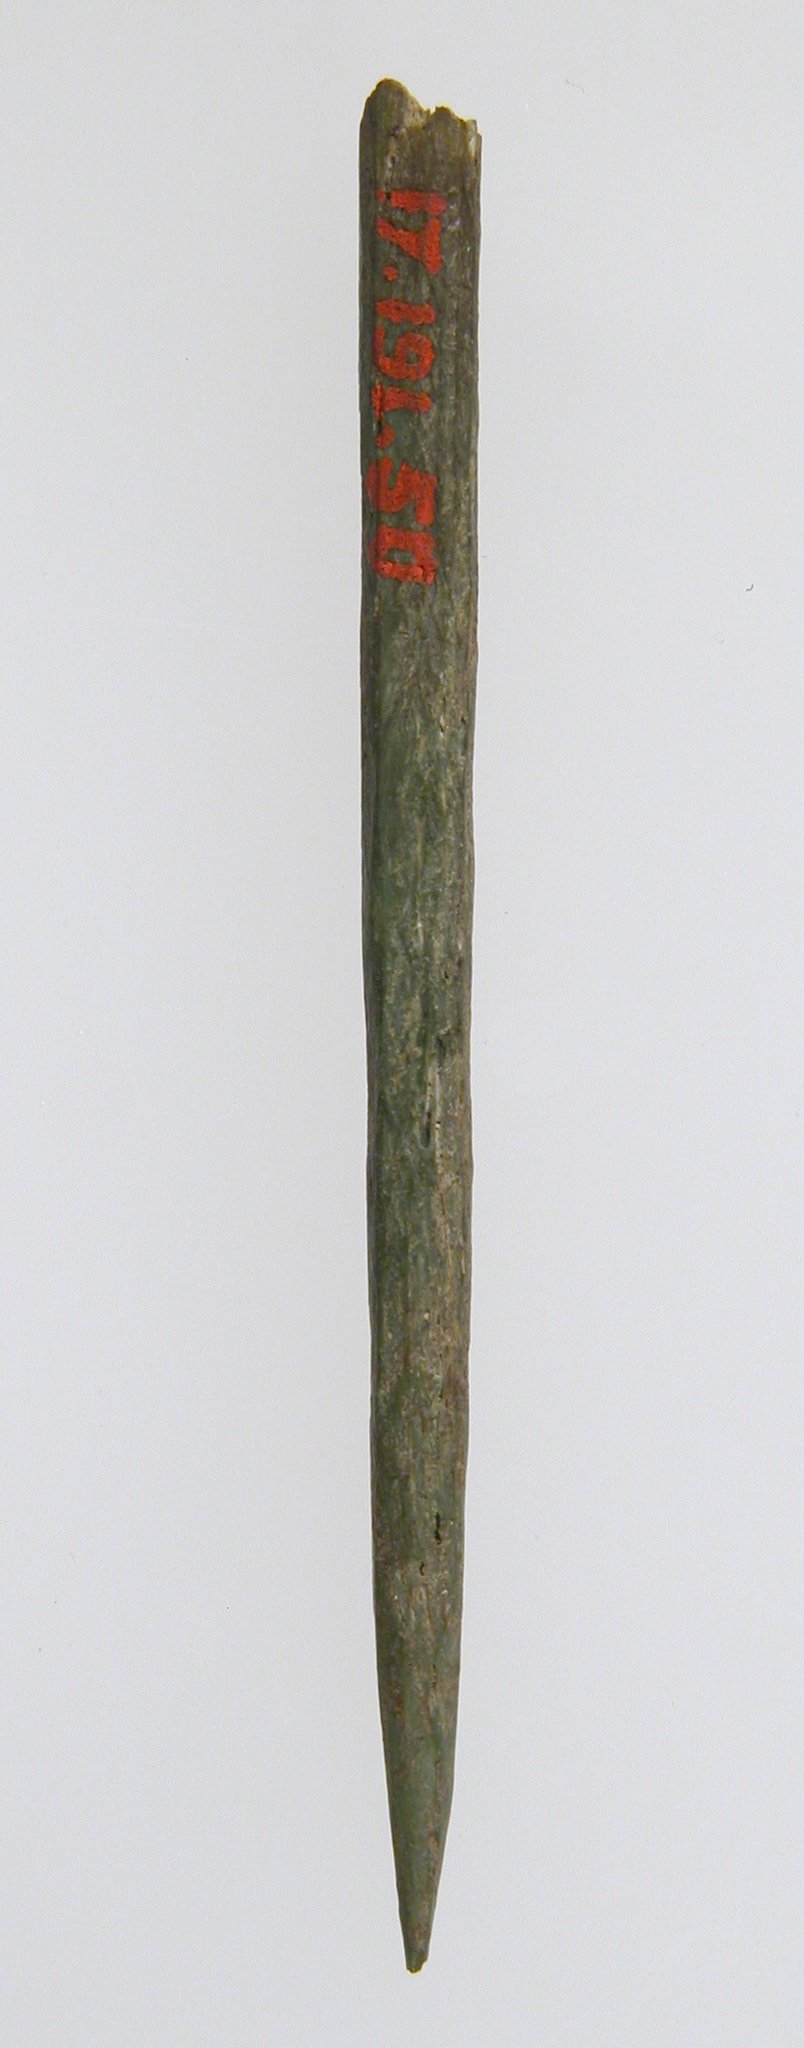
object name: hairpin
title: Hairpin Point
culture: roman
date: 1-400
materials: bone